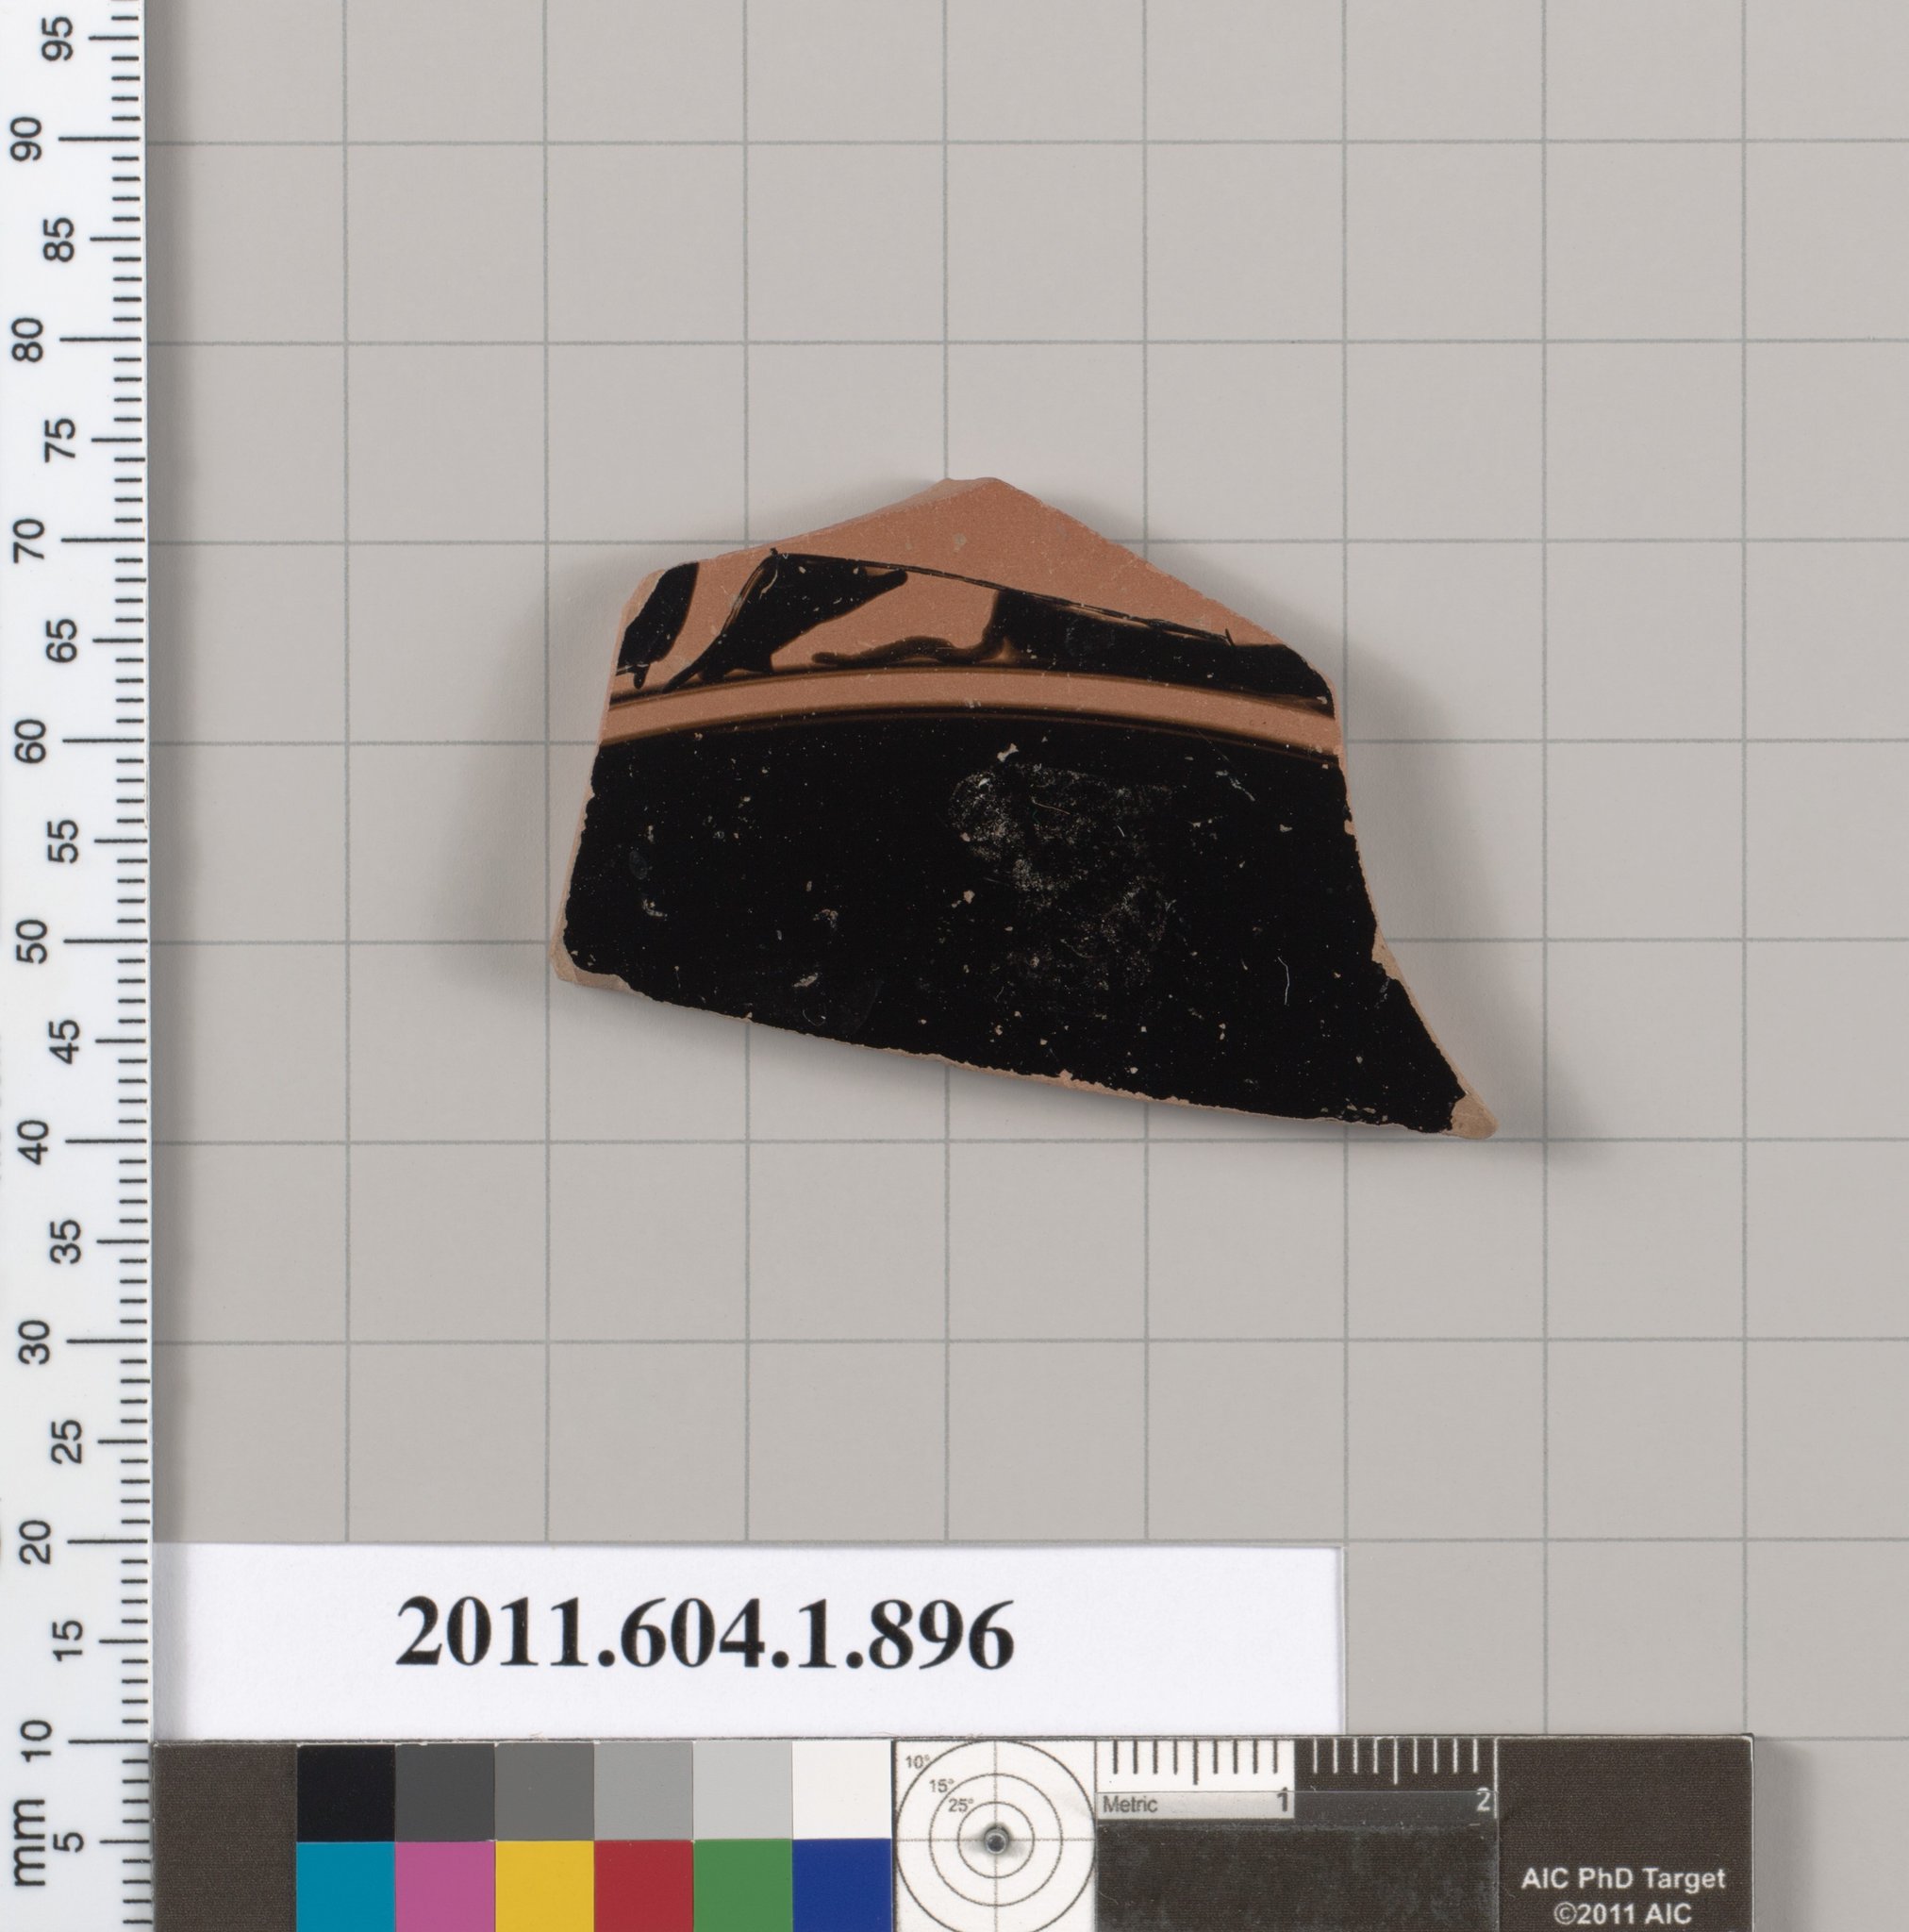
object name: kylix fragment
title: Terracotta fragment of a kylix (drinking cup)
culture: greek, attic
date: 475-451 BCE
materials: terracotta